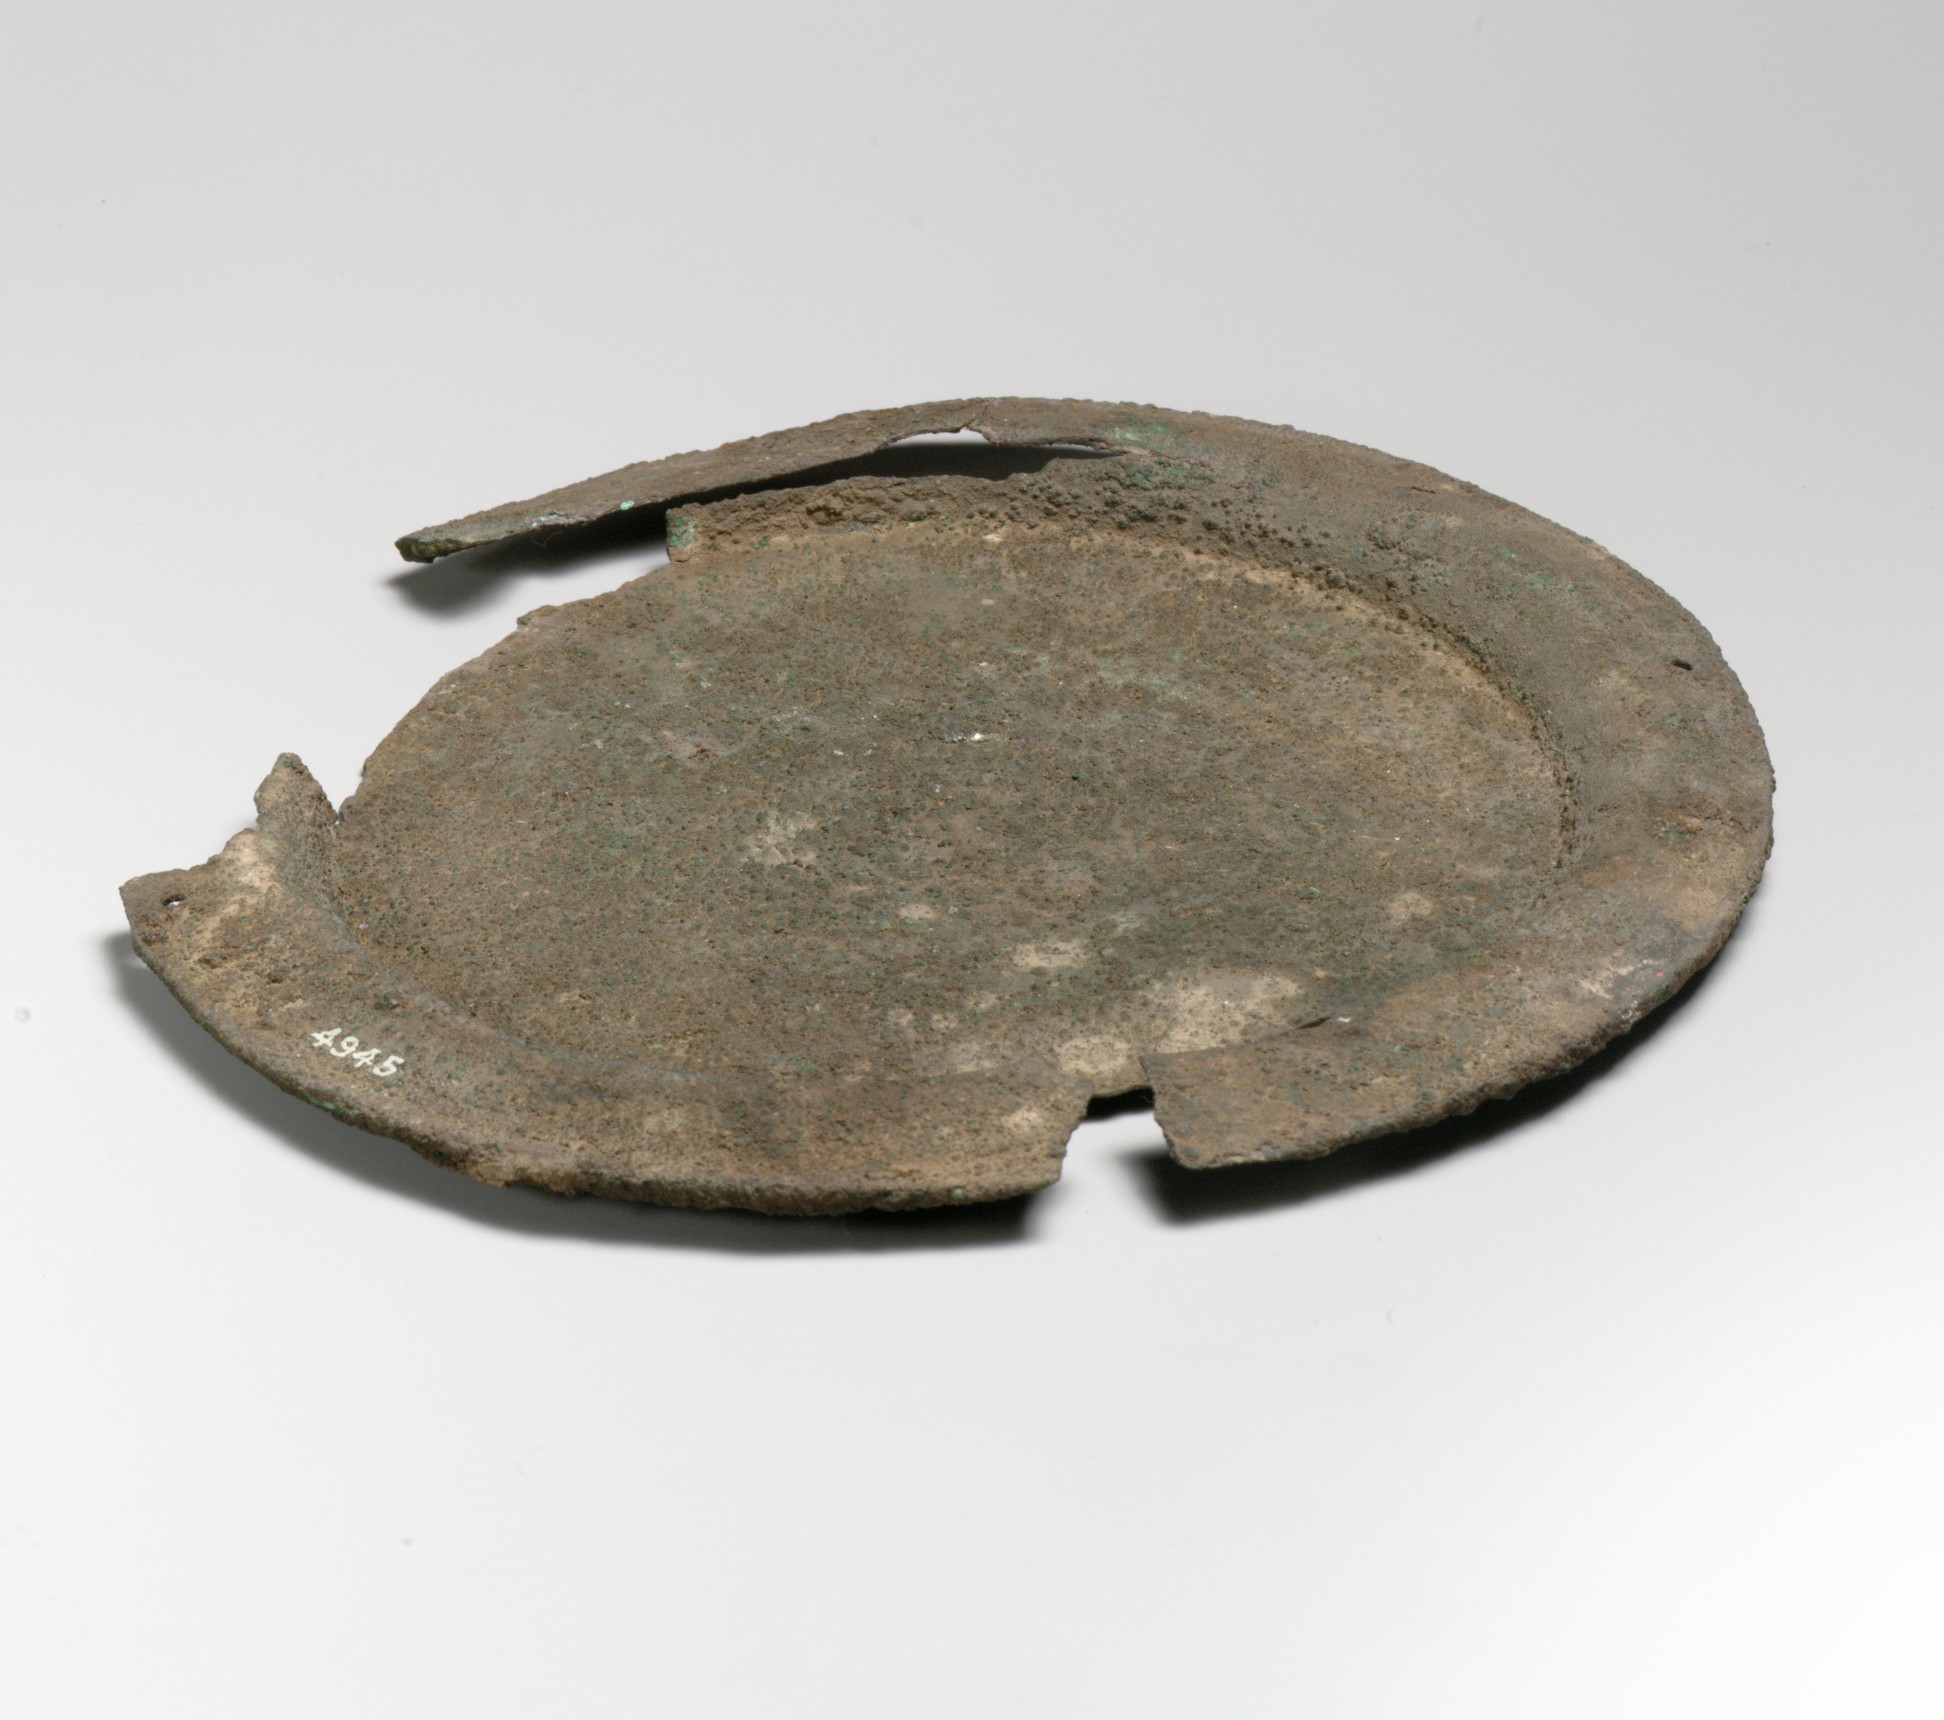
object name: plate with concentric circle incised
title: Plate with concentric circles incised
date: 7000 BCE-330 CE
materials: bronze